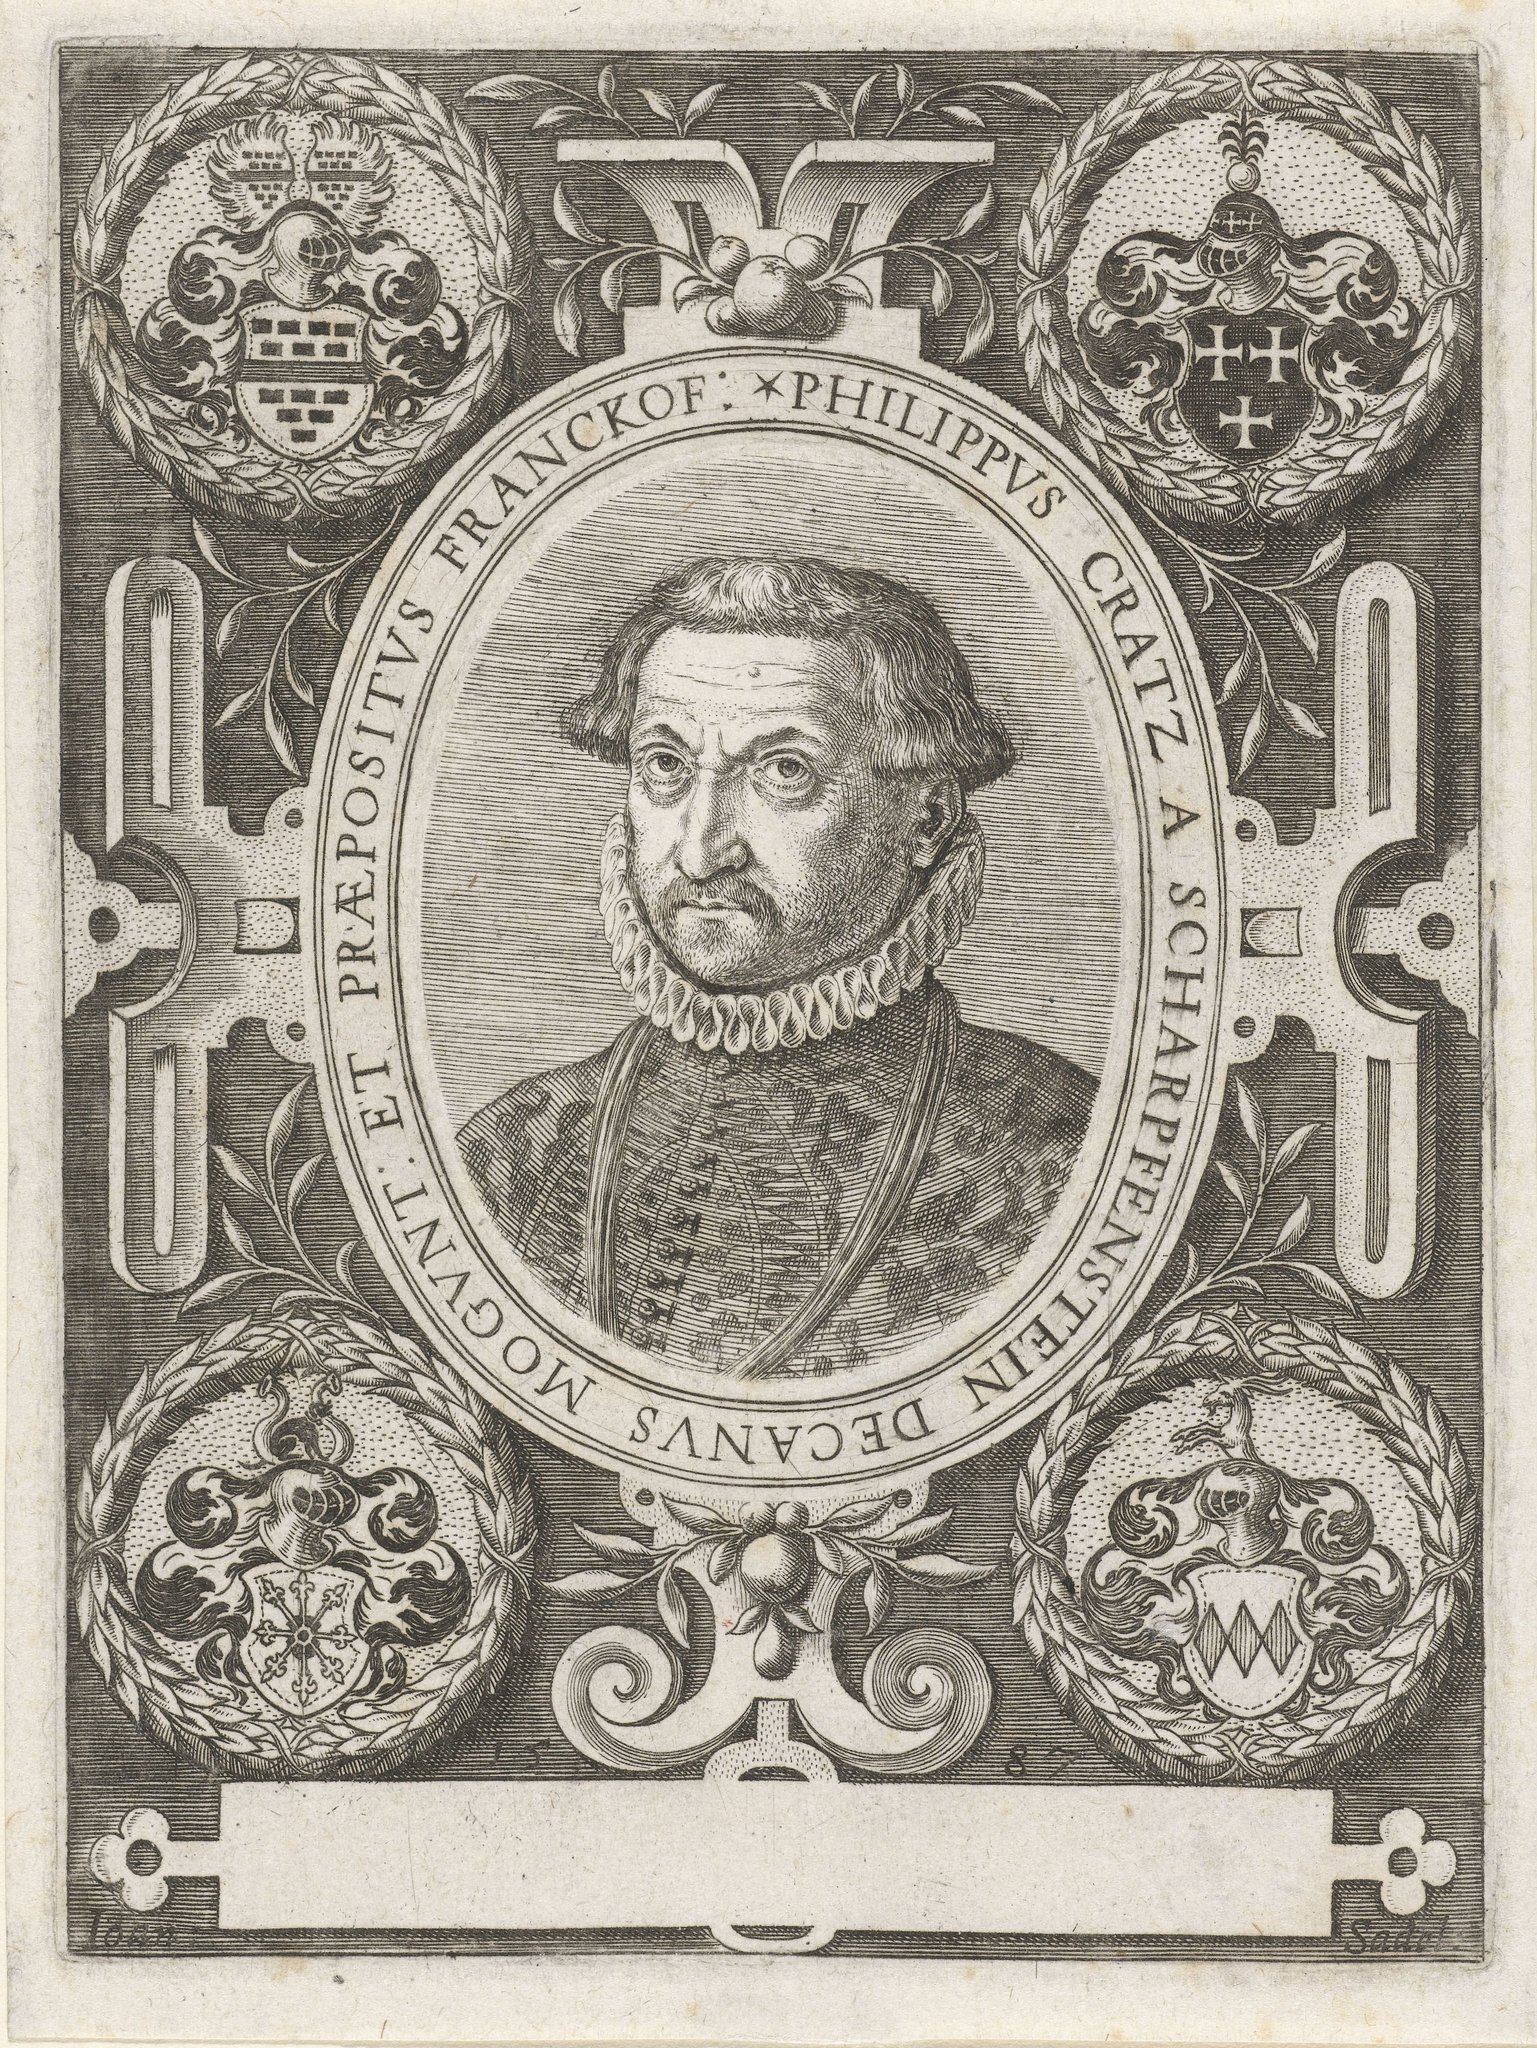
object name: print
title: Portret van Philipp Cratz van Scharffenstein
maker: johann sadeler (i)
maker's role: print maker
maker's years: 1550-1600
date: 1587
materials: paper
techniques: engraving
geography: frankfurt am main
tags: armorial bearing, heraldry - aa - female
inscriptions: collector's mark: Lugt 240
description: Philipp Cratz van Scharpfenstein, decaan van de universiteit van Frankfurt. In ornamentale omlijsting met in de vier hoeken een wapen. Aan de voet van het portret een leeg cartouche.